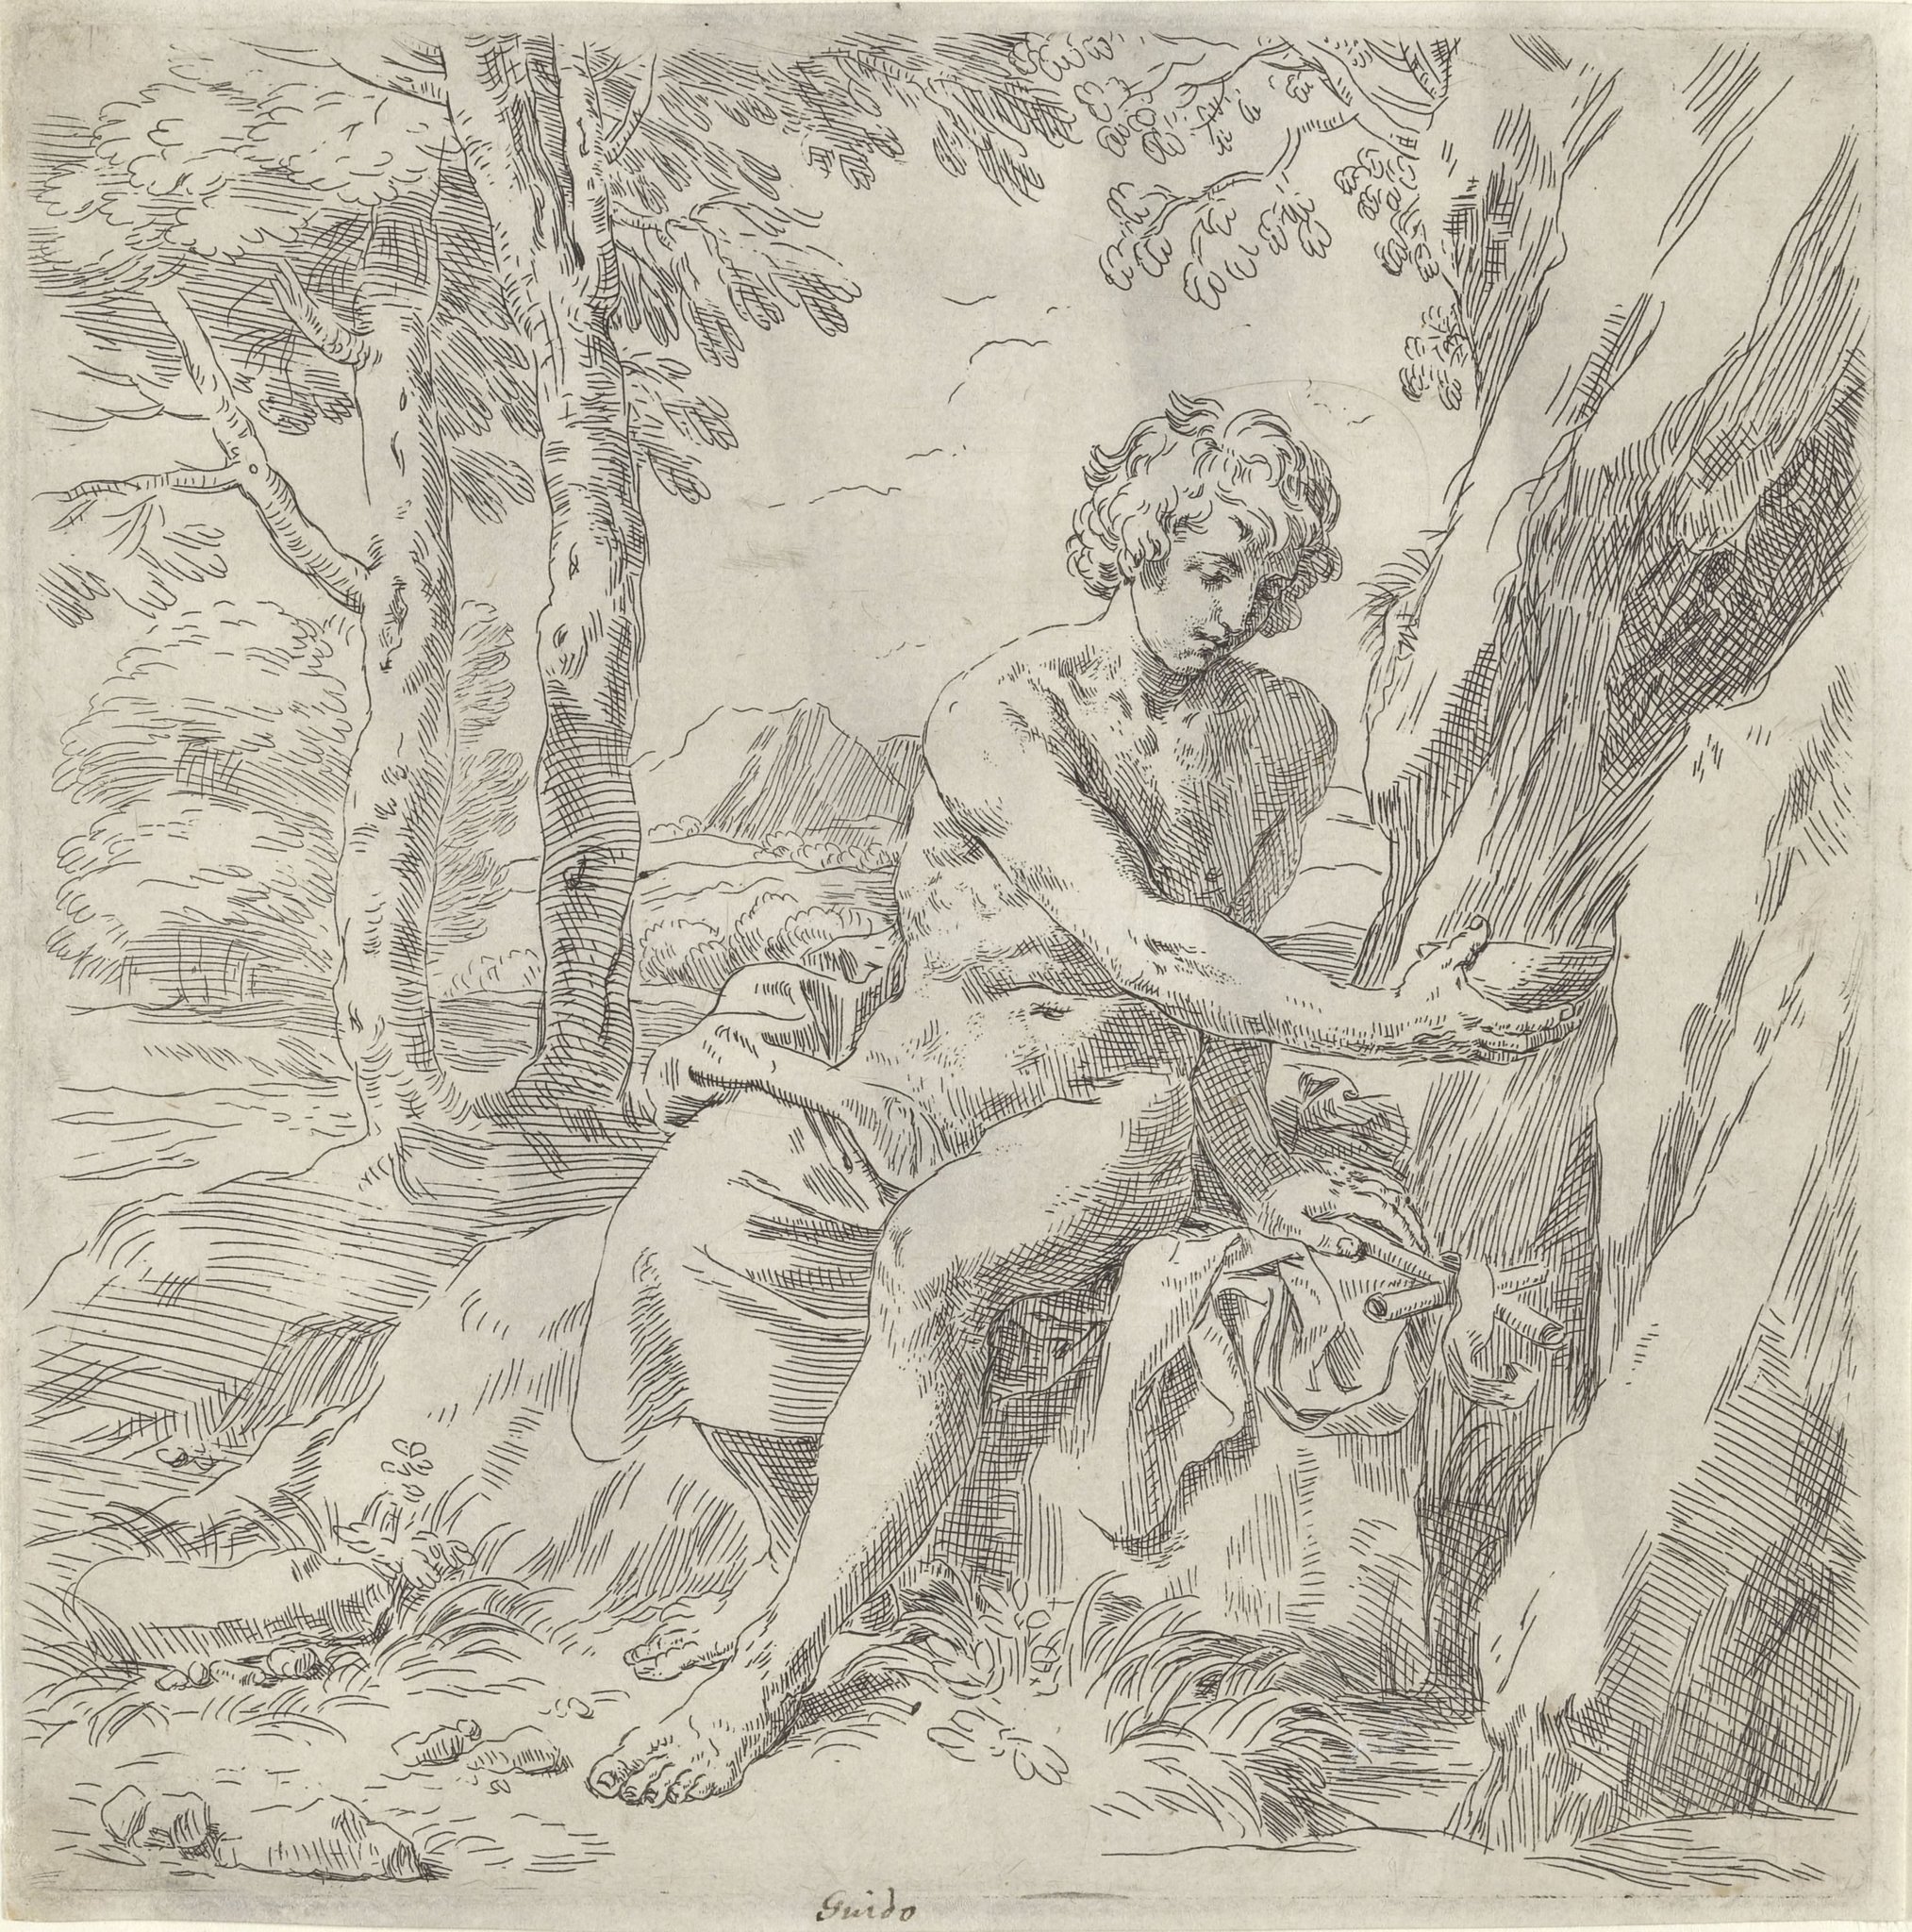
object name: print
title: Johannes de Doper in de wildernis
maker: simone cantarini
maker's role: draughtsman, print maker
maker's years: 1612-1648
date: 1622-1648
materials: paper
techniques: etching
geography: italy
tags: john the baptist in the wilderness, usually accompanied by a lamb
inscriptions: collector's mark: Lugt 240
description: Johannes de Doper zit bij een waterbron in een landschap. Hij vangt water op met een kom.